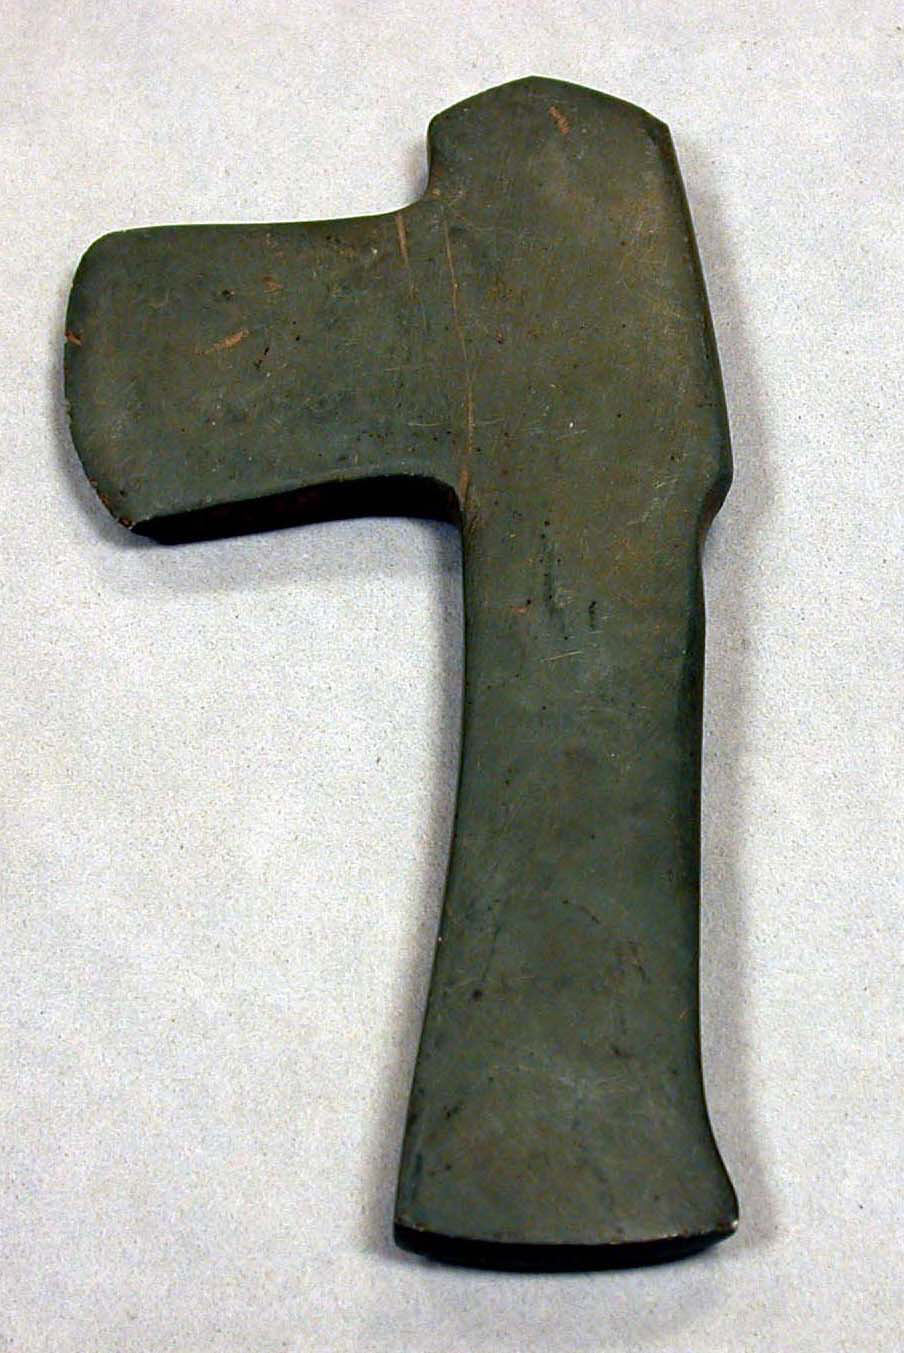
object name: axe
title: Ceremonial Axe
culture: tairona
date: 1501-1600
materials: stone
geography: colombia